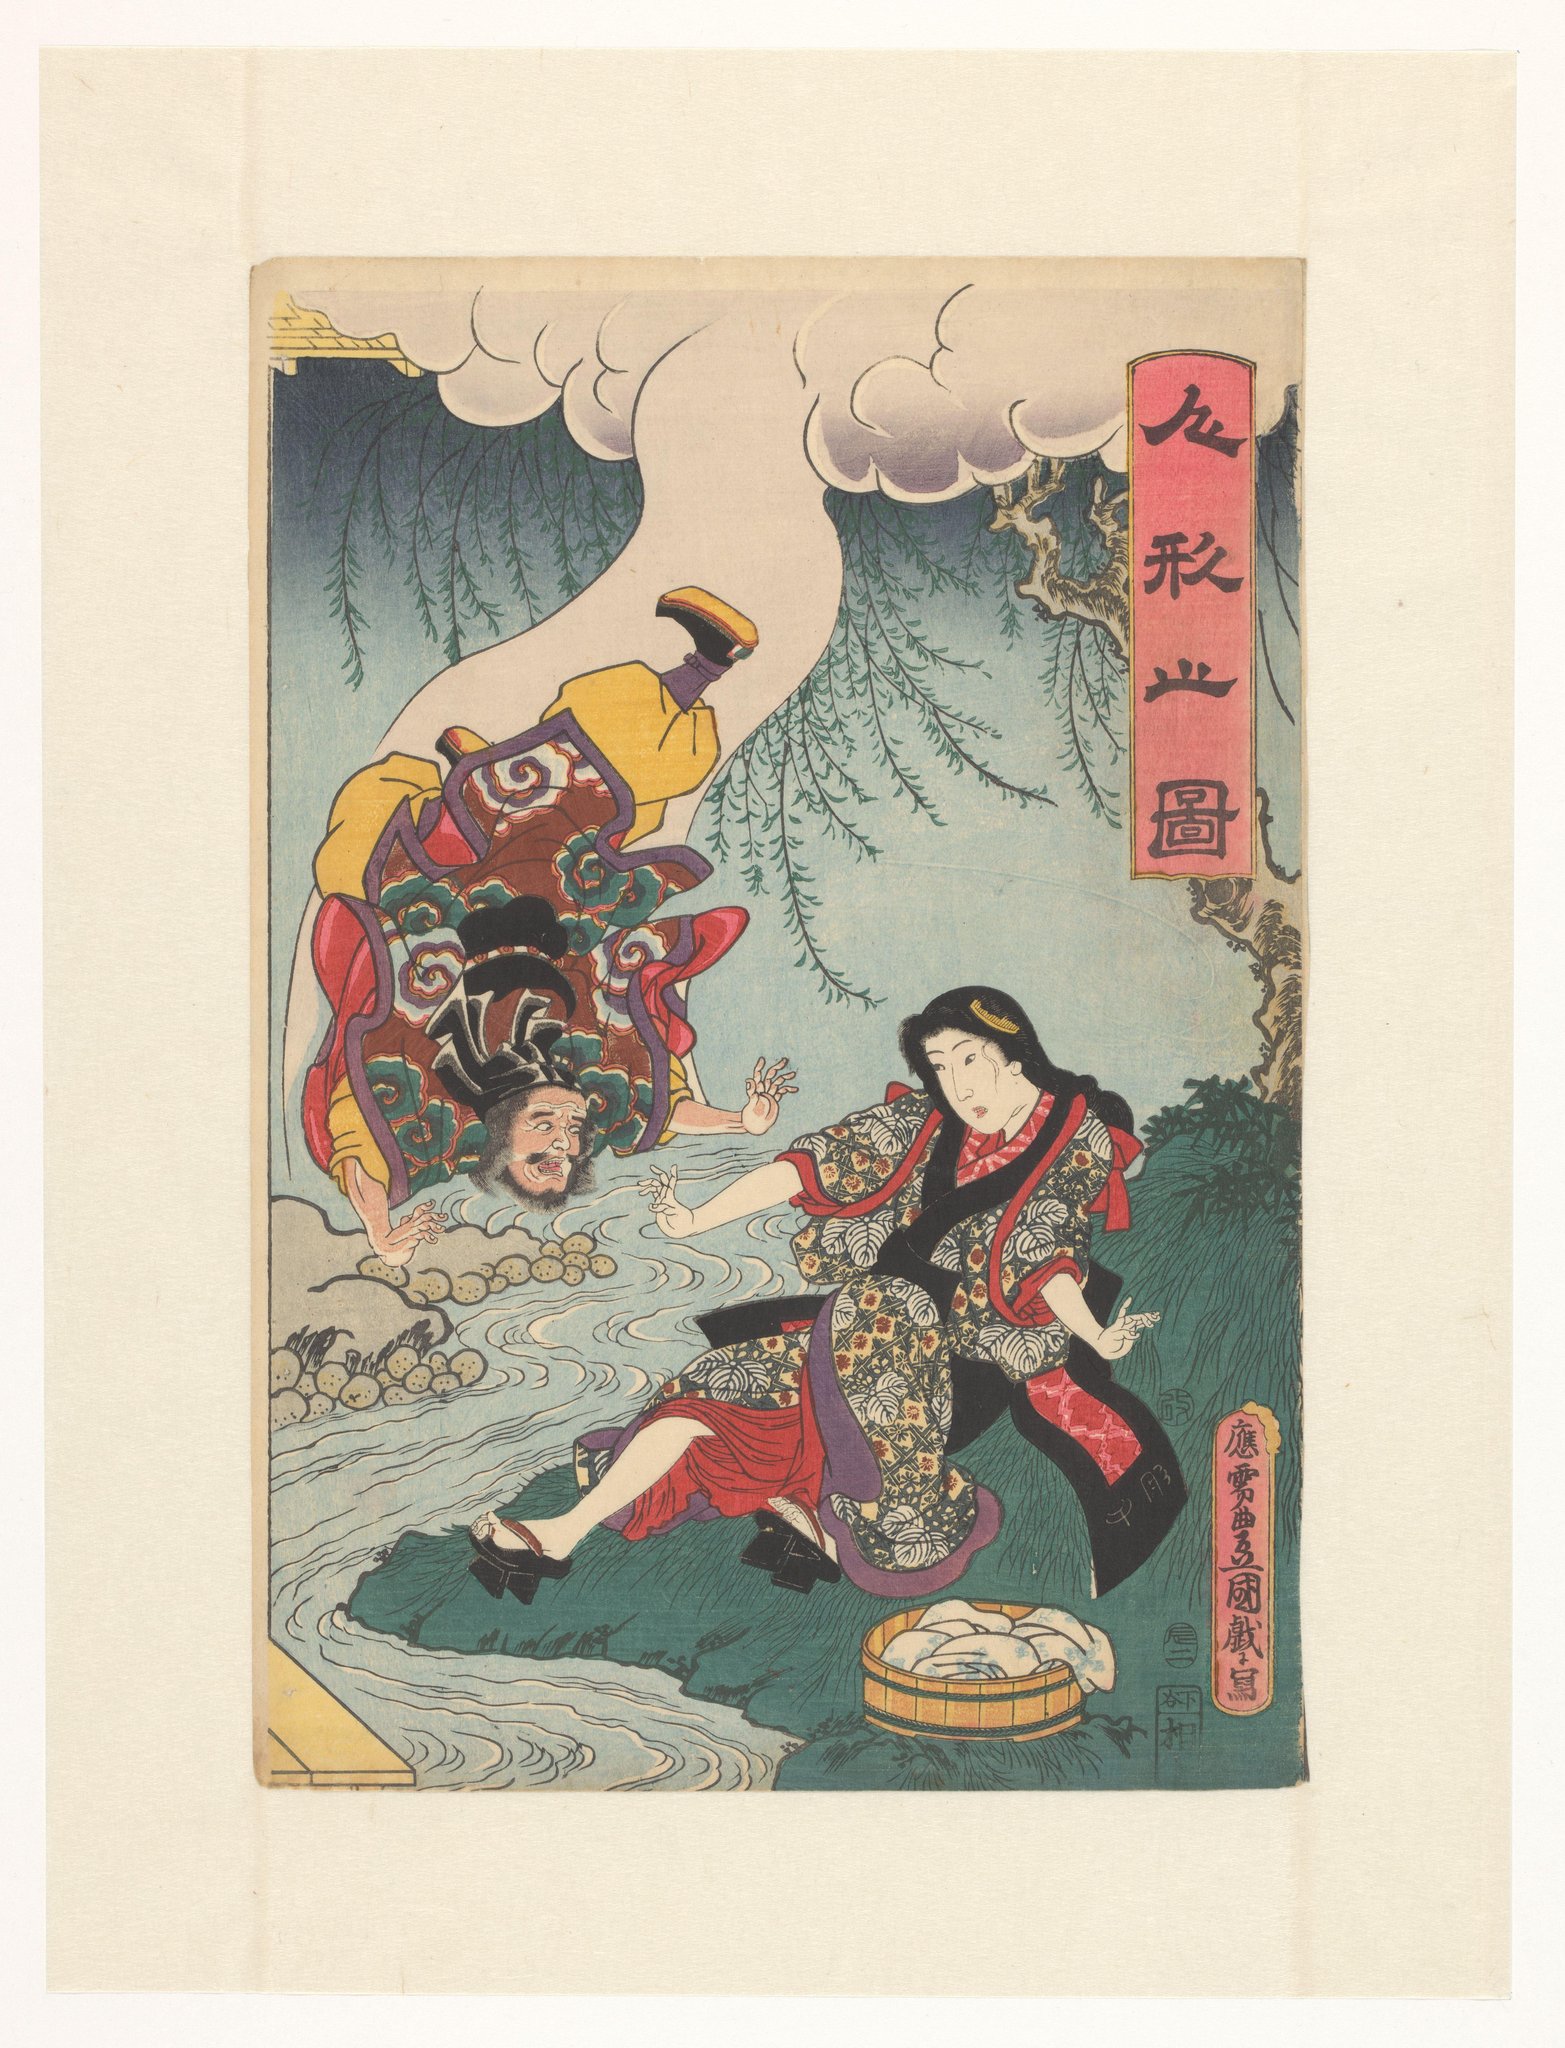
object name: print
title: Immortal falling from a cloud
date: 1802-1856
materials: paper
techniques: woodcut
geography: japan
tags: river, laundering, falling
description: De onsterfelijke Kume Sennin valt uit de lucht bij het zien van de ontblote benen een jonge vrouw die langs de rivier de Yoshino de was aan het doen is. Sennin beheerste de kunst van het vliegen, maar het zien van deze benen vervulde hem zodanig met passie, dat hij zijn kracht verloor en uit de lucht viel, vlak voor de vrouw. Later zouden ze met elkaar trouwen.